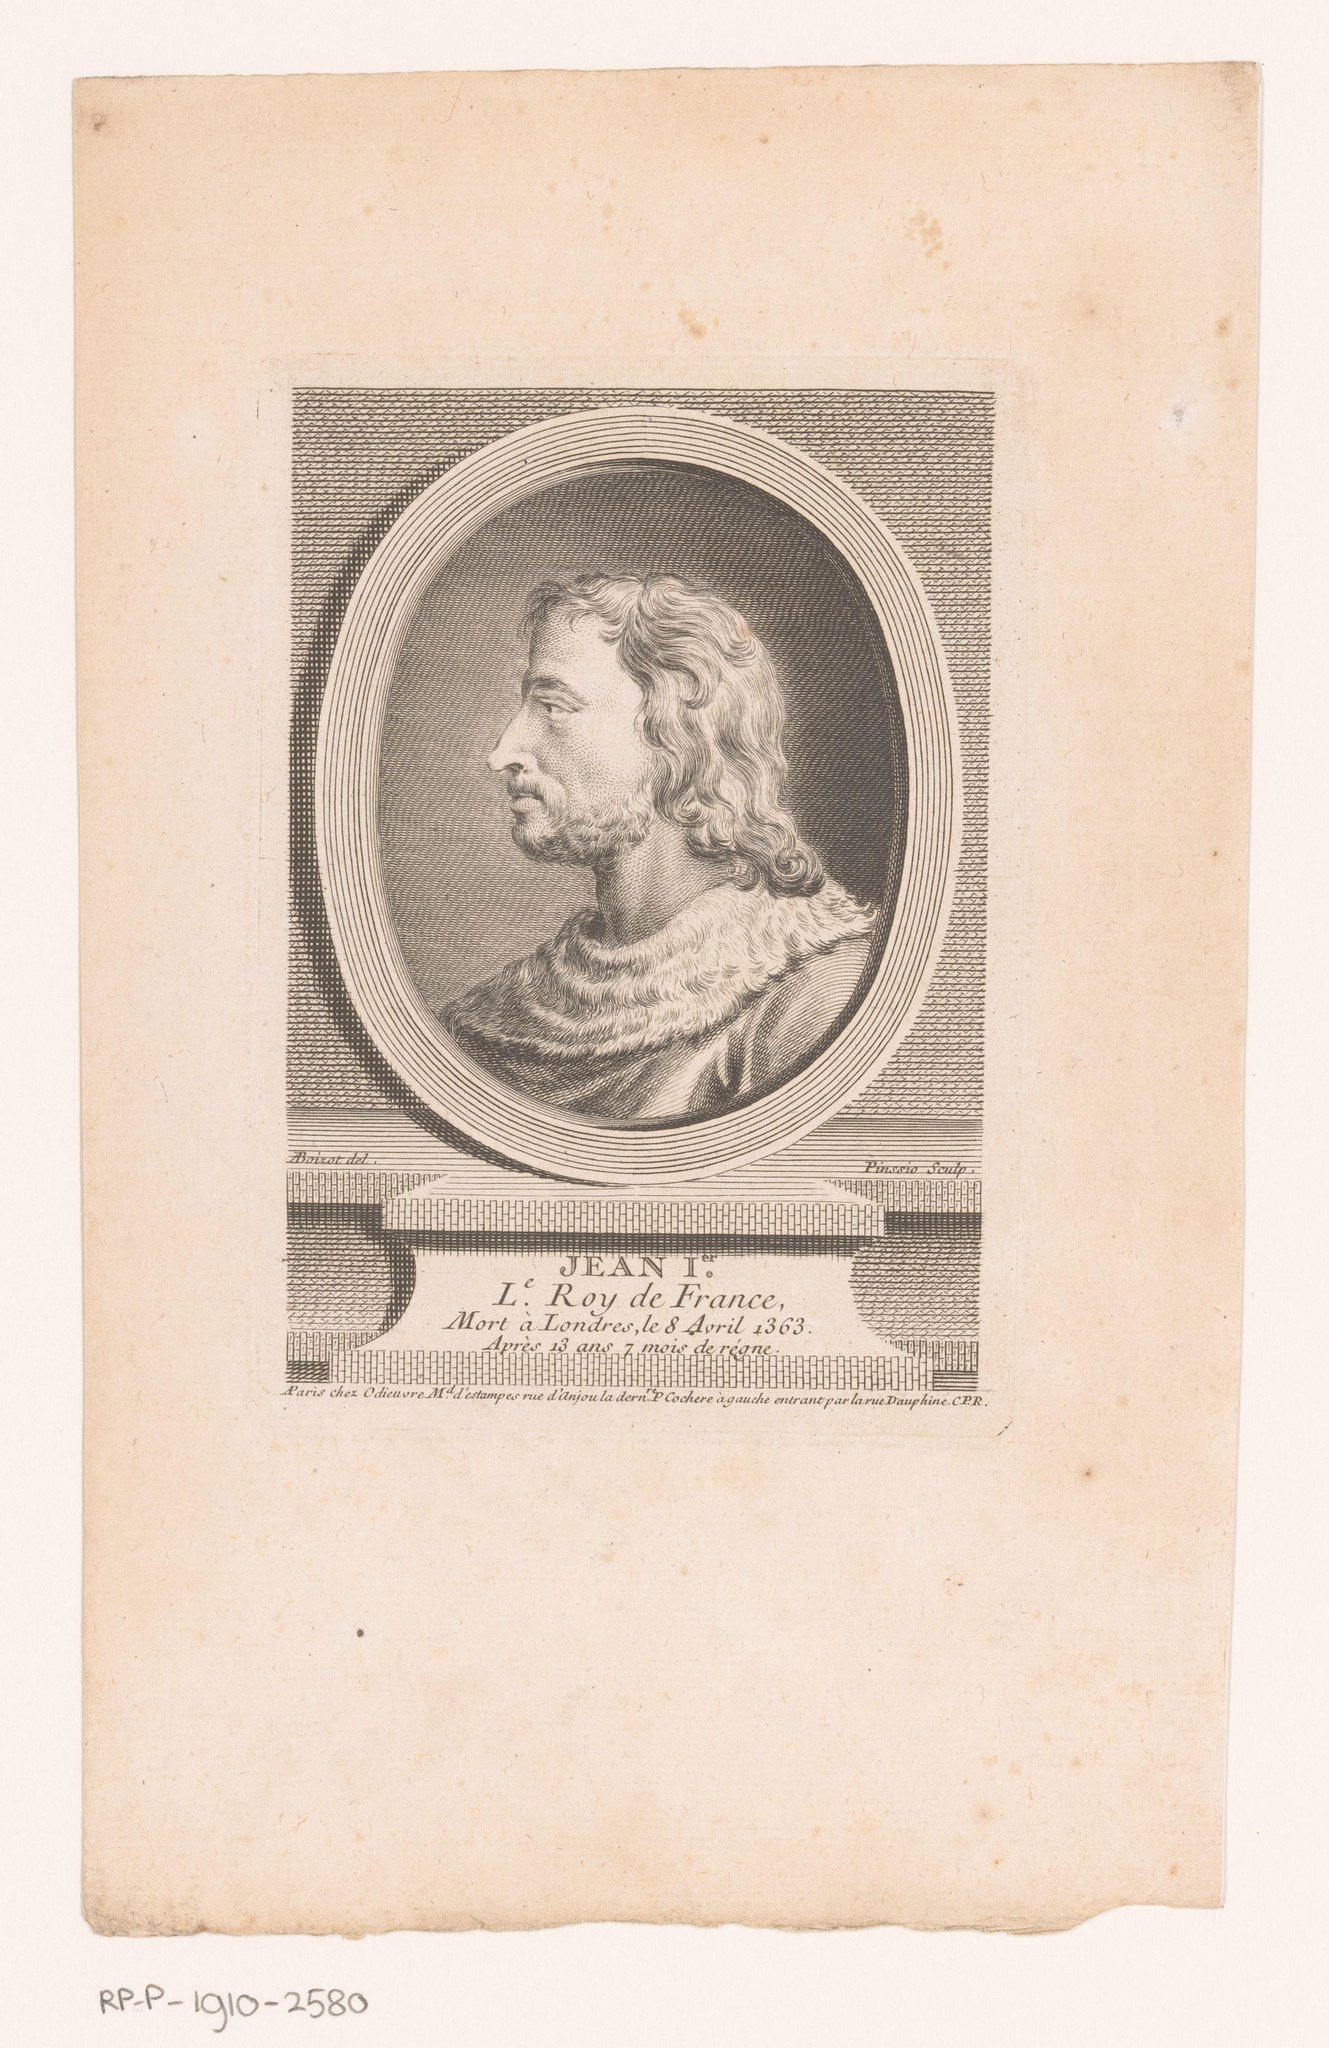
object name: print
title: Jean I.er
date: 1755-1765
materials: paper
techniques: engraving, etching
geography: france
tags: london, historical persons, king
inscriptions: collector's mark: Lugt 2228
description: Prent uit: Dreux du Radier, Jean-François. L'Europe illustré, contenant l'histoire abregée des souverains, des princes, des prélats, des ministres, (...) en Europe: dans le XVe. siècle compris, jusqu'à présent. Parijs: Michel Odieuvre en André-François Le Breton, 1755-1765.